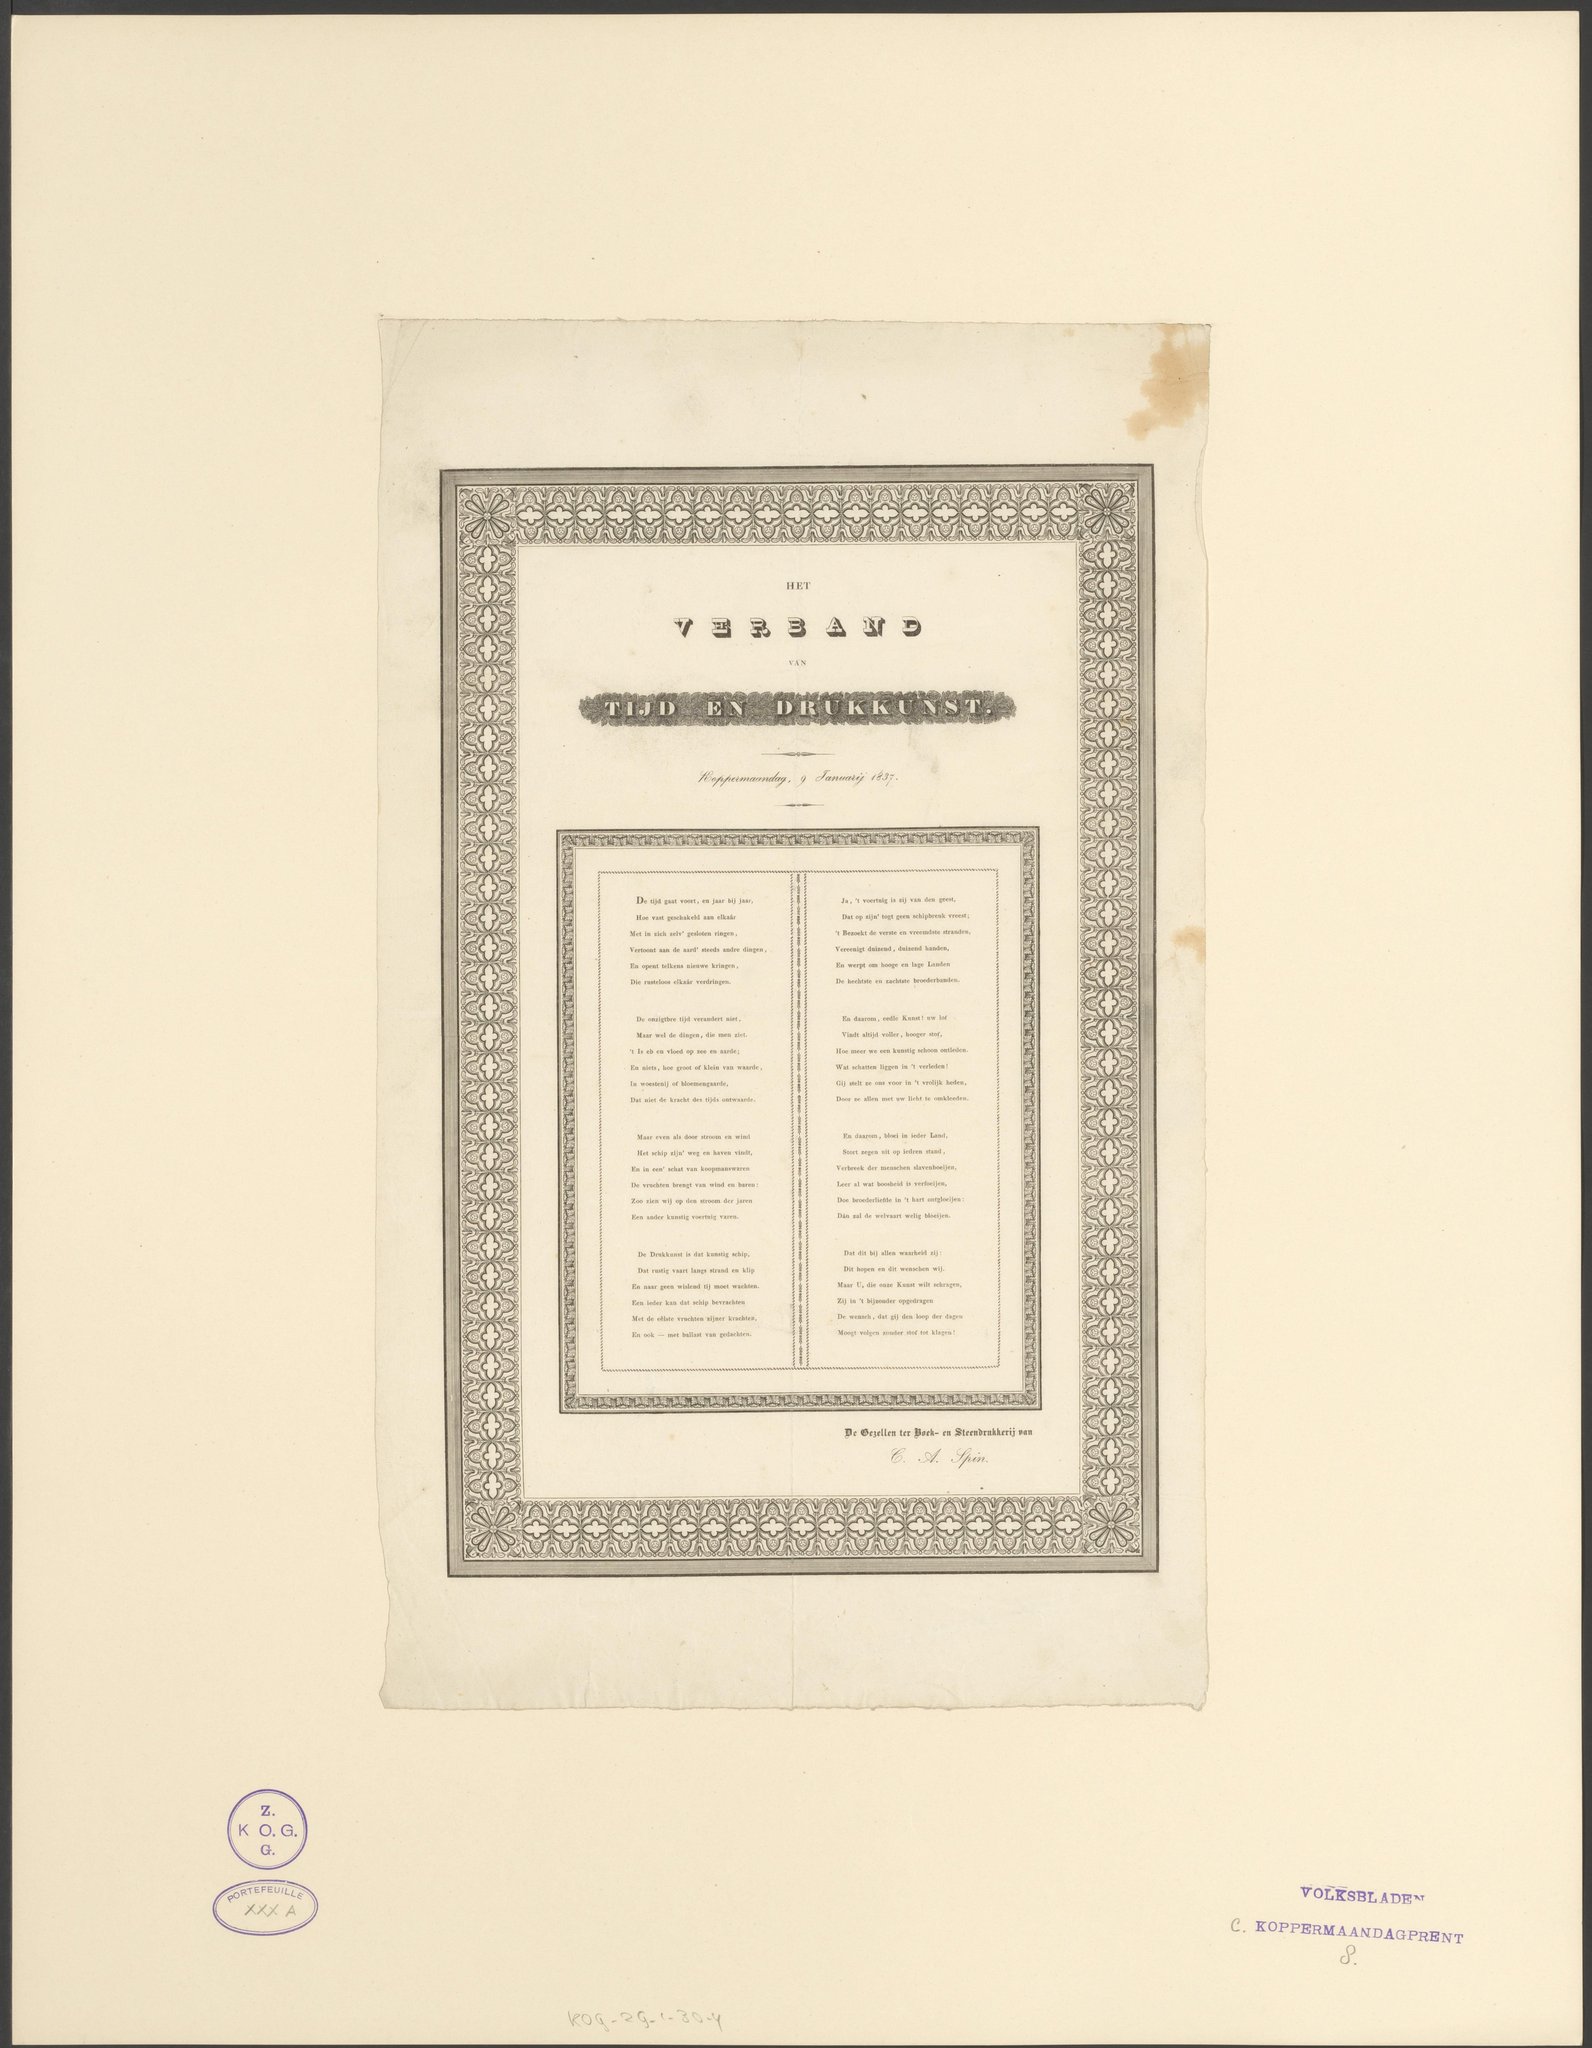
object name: text sheet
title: Het verband van tijd en drukkunst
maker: christiaan andersen spin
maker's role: printer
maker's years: 1792-1865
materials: paper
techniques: letterpress printing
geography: amsterdam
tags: printing press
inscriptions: collector's mark: Lugt 1641, stamp, stamp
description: Koppermaandagprent met lofzang op de boekdrukkunst en de tijd, voor Koppermaandag 9 januari 1837. Met een vers in twee kolommen. Onderwerpsrubrieken binnen de Atlas Zeden en Gewoonten: Zeden en Gewoonten in engeren zin. Volksleven. Volksbladen. Koppermaandagwenschen.